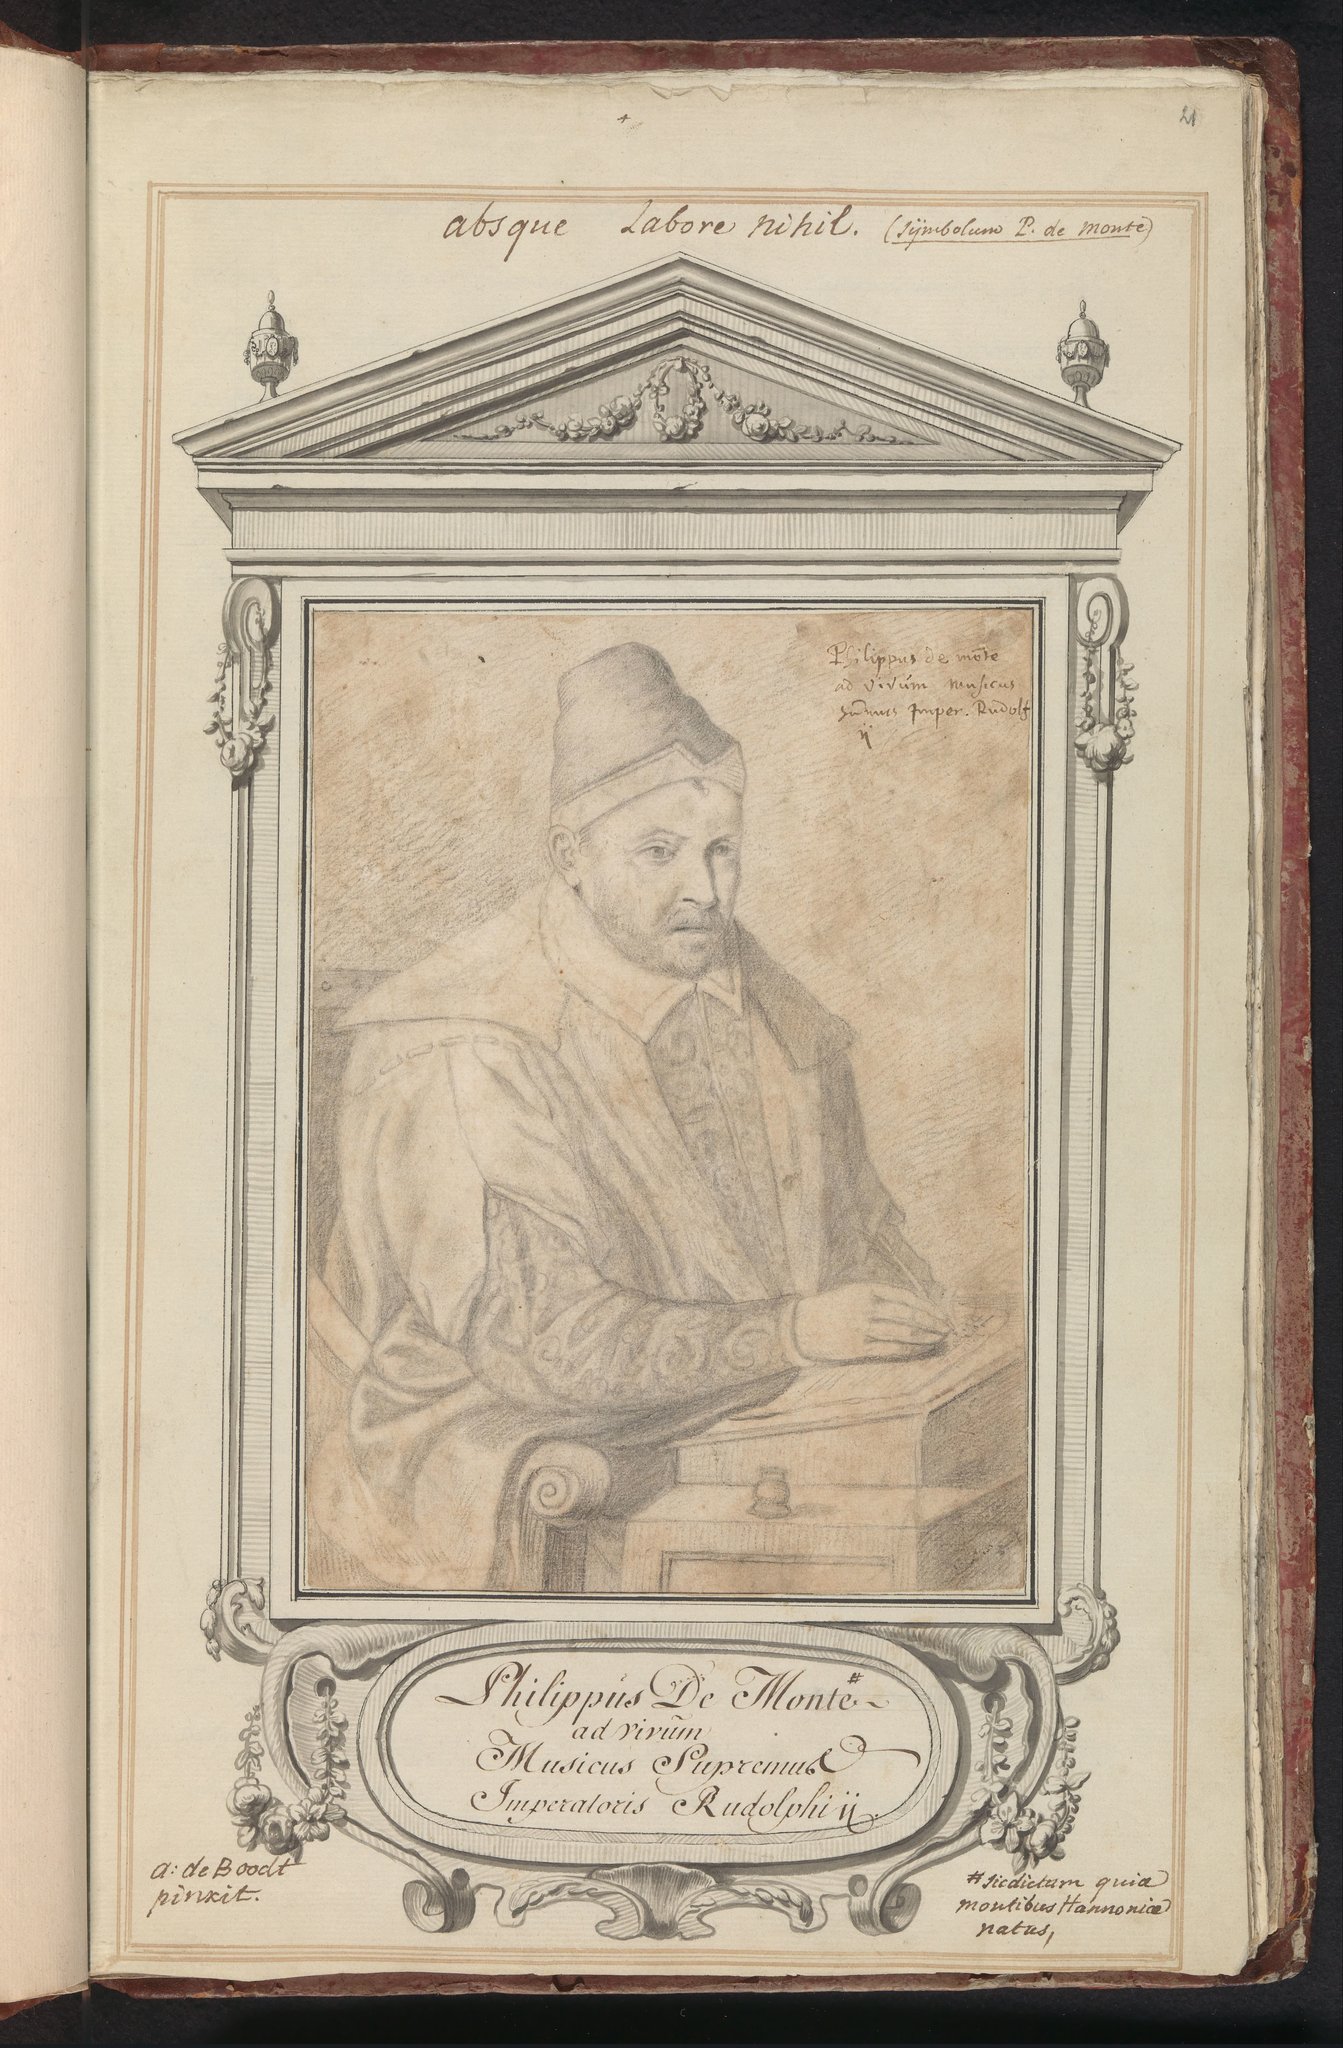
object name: drawing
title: Portret van Philippus de Monte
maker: anselmus boëtius de boodt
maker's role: draughtsman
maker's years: 1550-1632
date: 1596-1603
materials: ink, paper, pencil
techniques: brush, pen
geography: prague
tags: philippus de monte, portrait of composer, prague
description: Portret van de componist Philippus de Monte, kapelmeester aan het hof van Rudolf II in Praag. De componist zittend schrijvend aan een schrijftafel, het portret in een decoratieve omlijsting. Onderdeel van het eerste album met tekeningen van viervoeters. Eerste van twaalf albums met tekeningen van dieren, vogels en planten bekend rond 1600, gemaakt in opdracht van keizer Rudolf II. Met toelichting in Nederlands, Latijn en Frans.